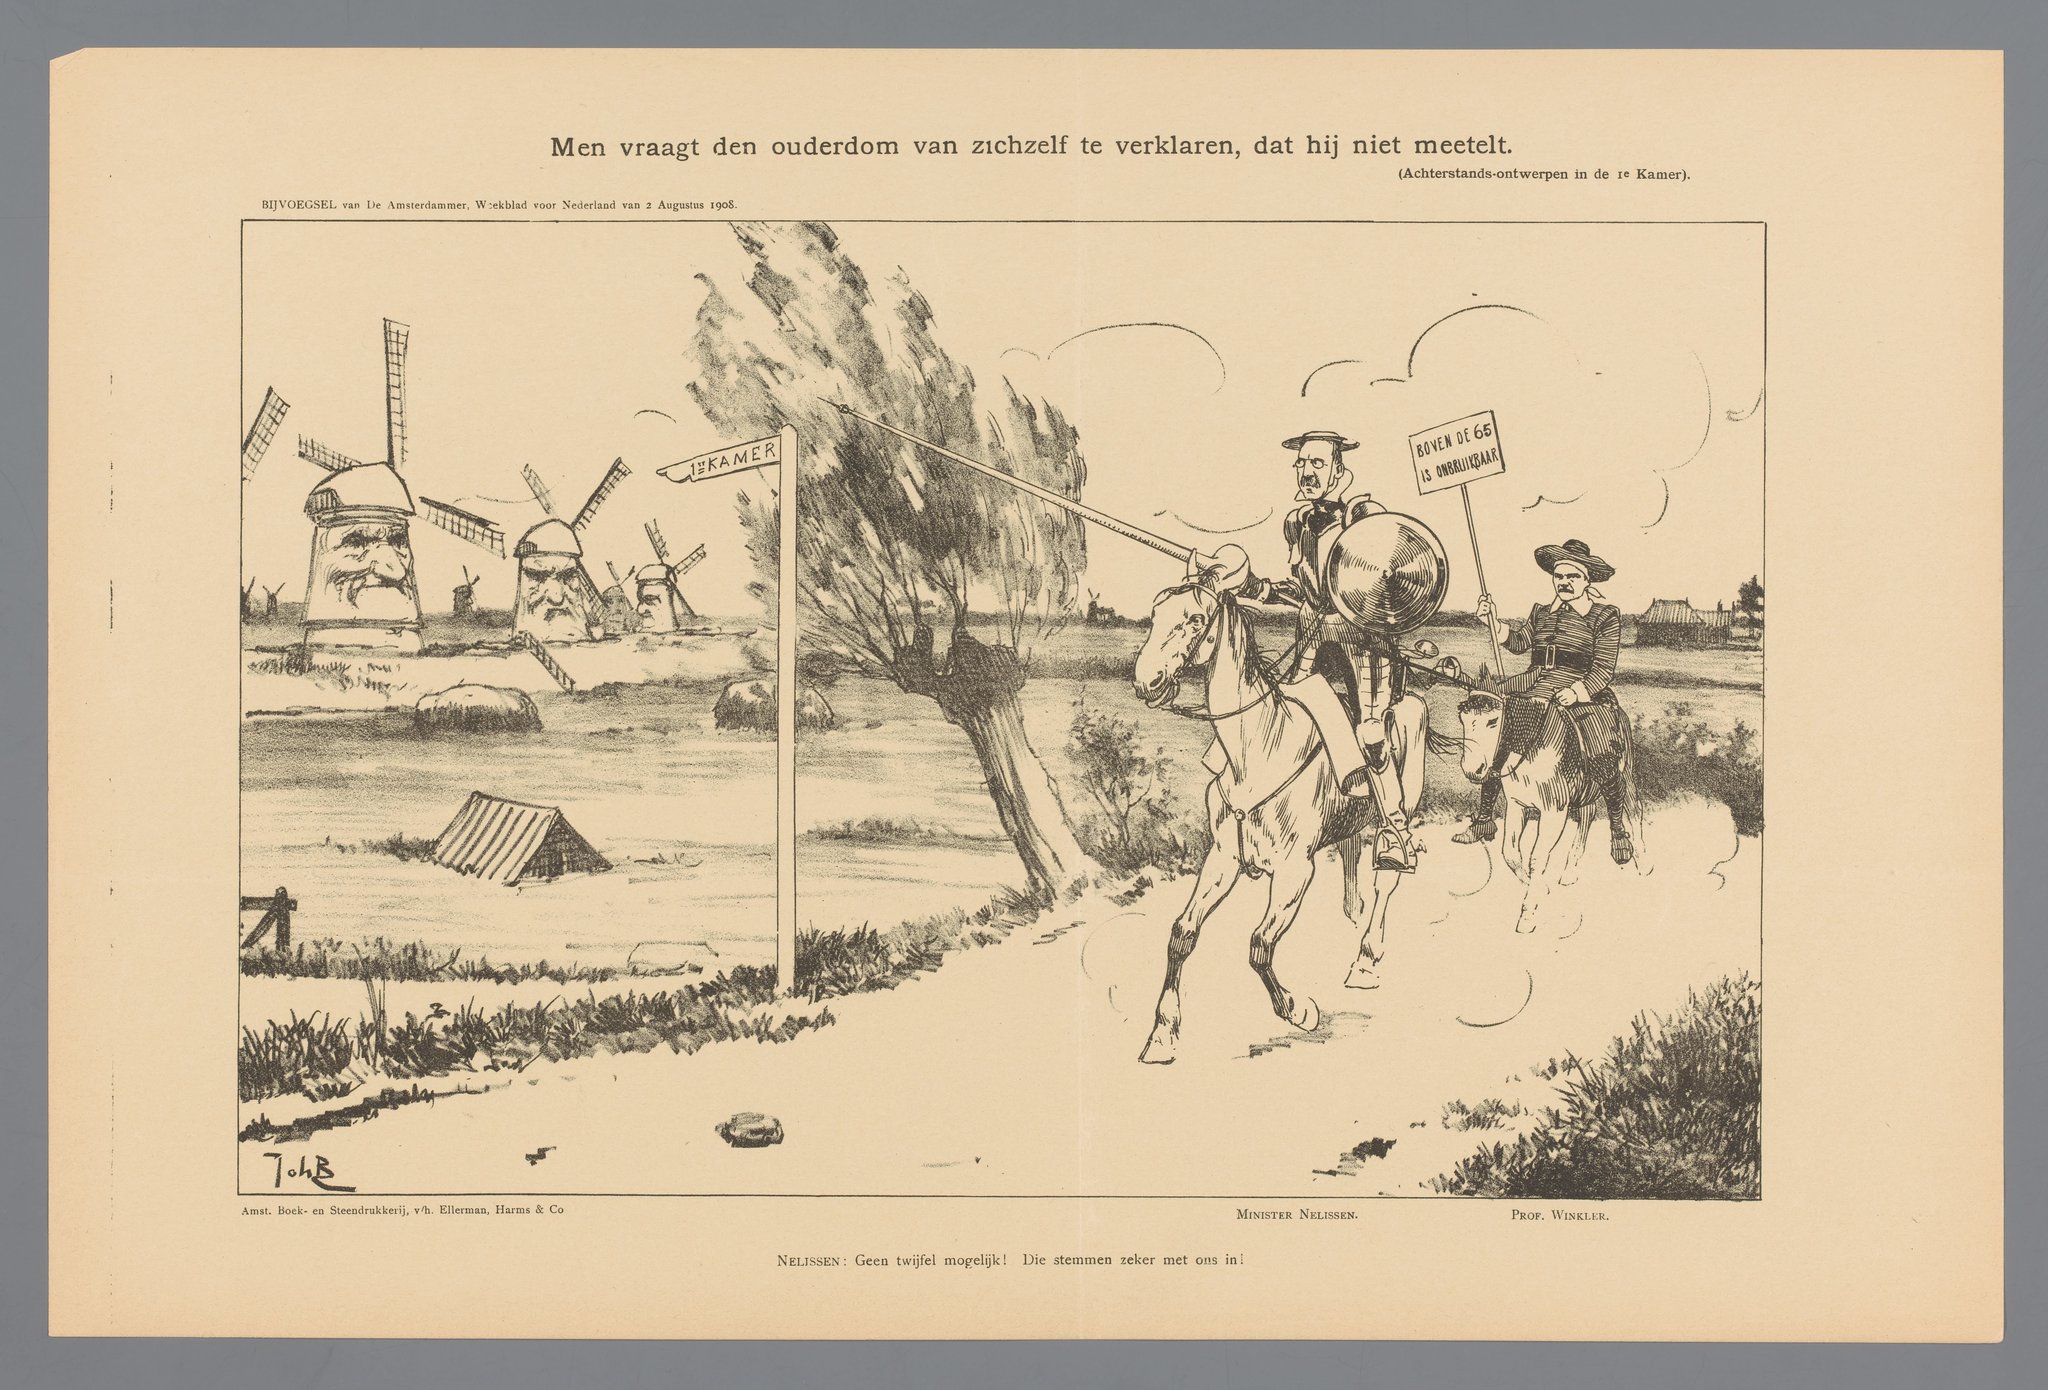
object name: cartoon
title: Men vraagt den ouderdom van zichzelf te verklaren, dat hij niet meetelt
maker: johan braakensiek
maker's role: draughtsman, print maker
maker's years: 1858-1940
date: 1908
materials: paper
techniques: lithograph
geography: amsterdam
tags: cornelis winkler, (scenes from) specific works of literature (with author, title), historical persons, professor, windmill, political caricatures and satires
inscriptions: date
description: Prent uit het bijvoegsel van: De Amsterdammer. Weekblad voor Nederland, 2 augustus 1908.